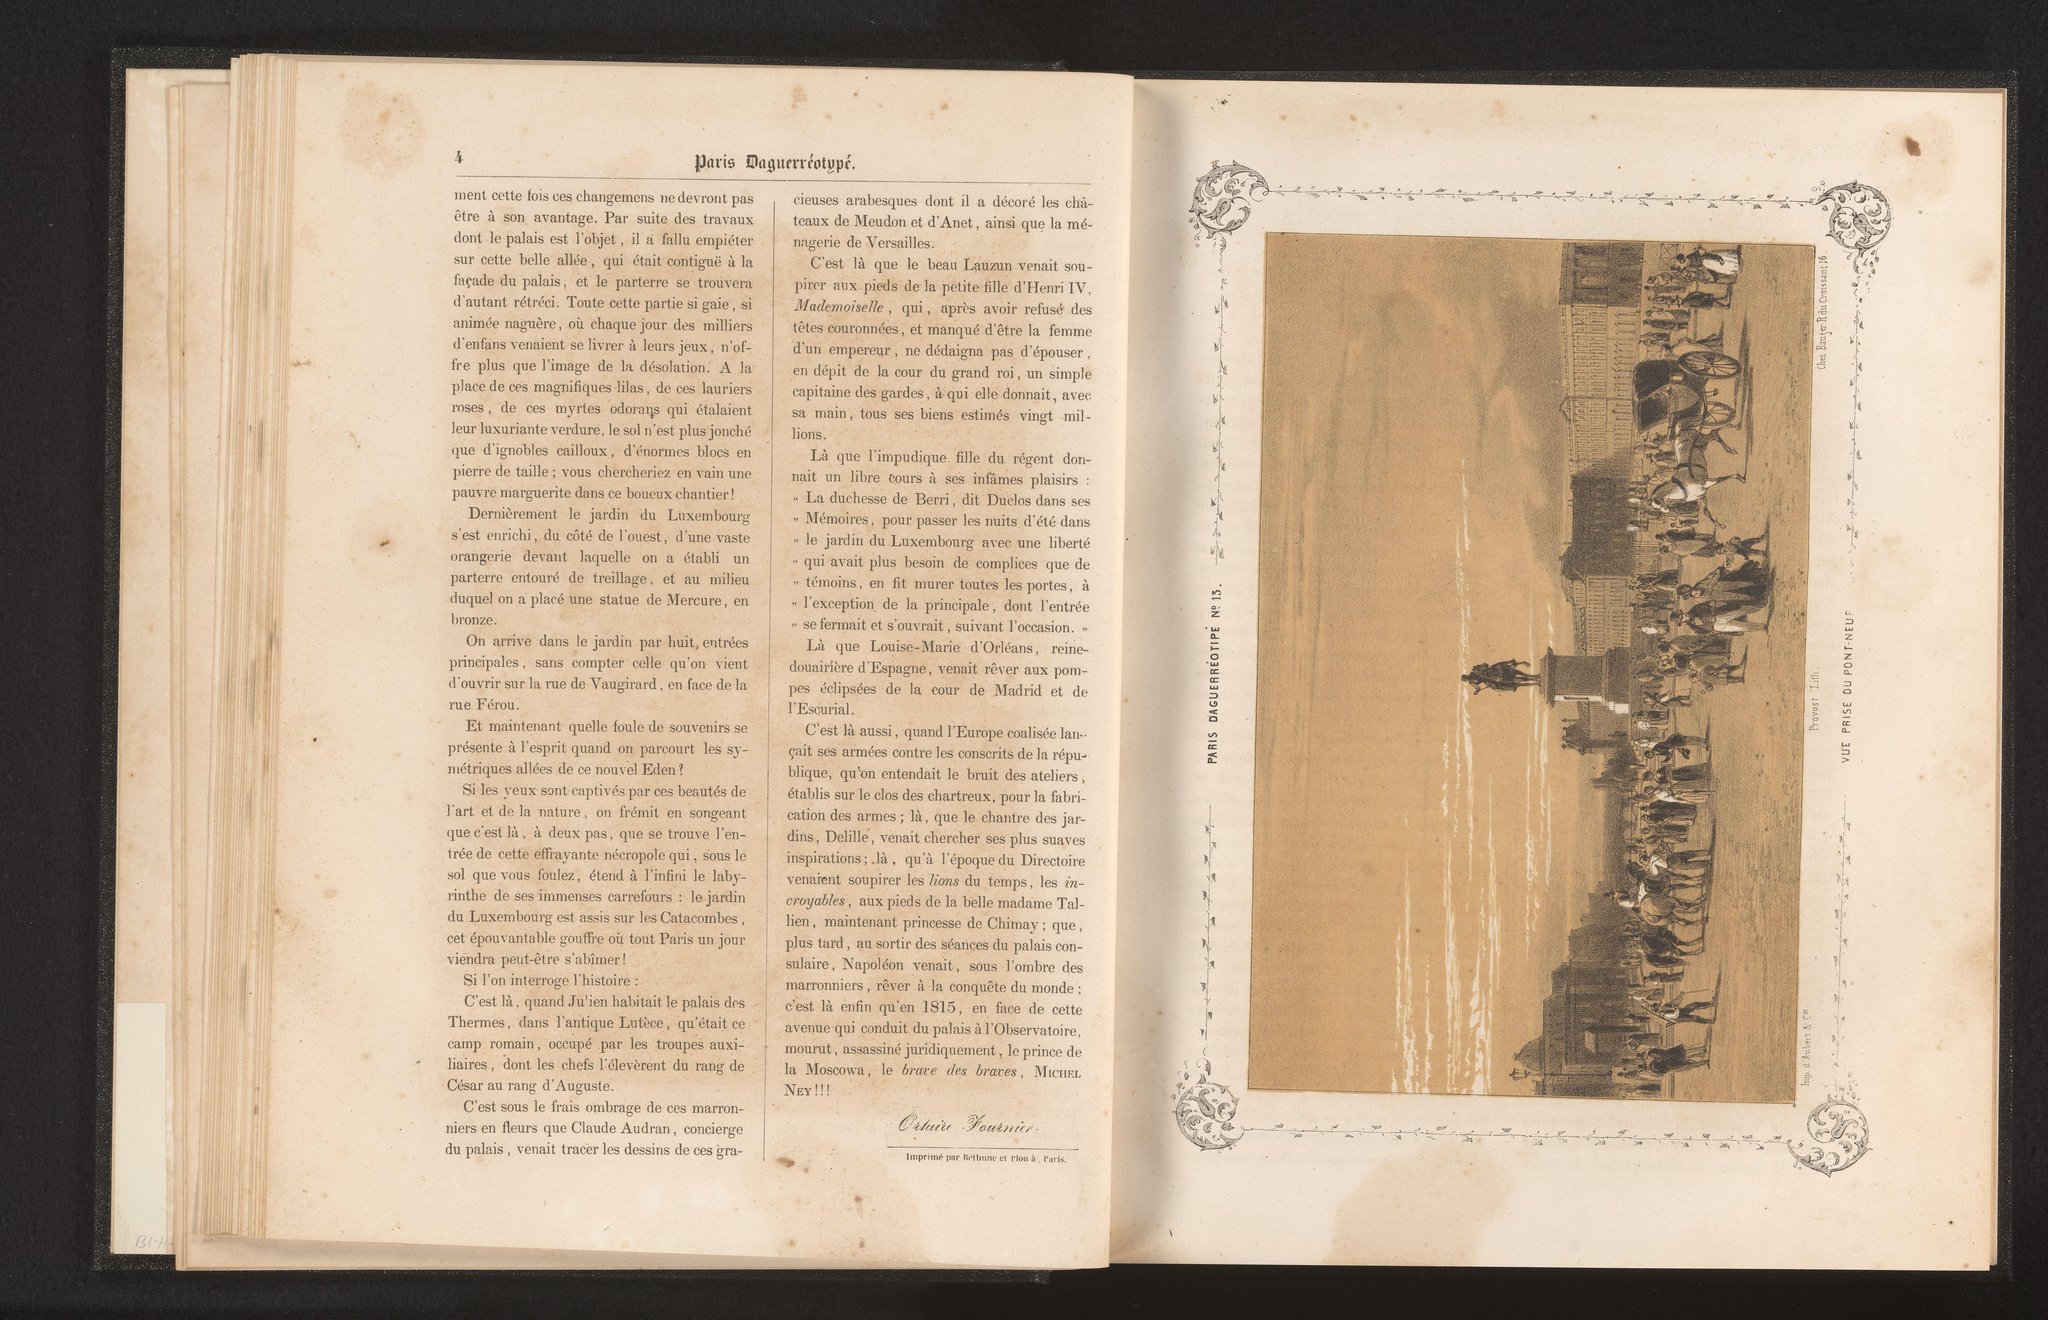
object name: print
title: Vue pris du Pont Neuf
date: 1839-1840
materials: paper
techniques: tone lithography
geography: paris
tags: city-view in general; 'veduta'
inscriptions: inscription: ‘PARIS DAGUERRÉOTYPÉ No. 13.’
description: Prent op negenenveertigste ongenummerde pagina.